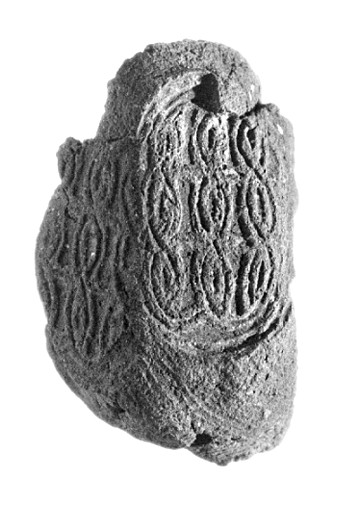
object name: sealing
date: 1981-1640 BCE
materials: mud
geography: egypt